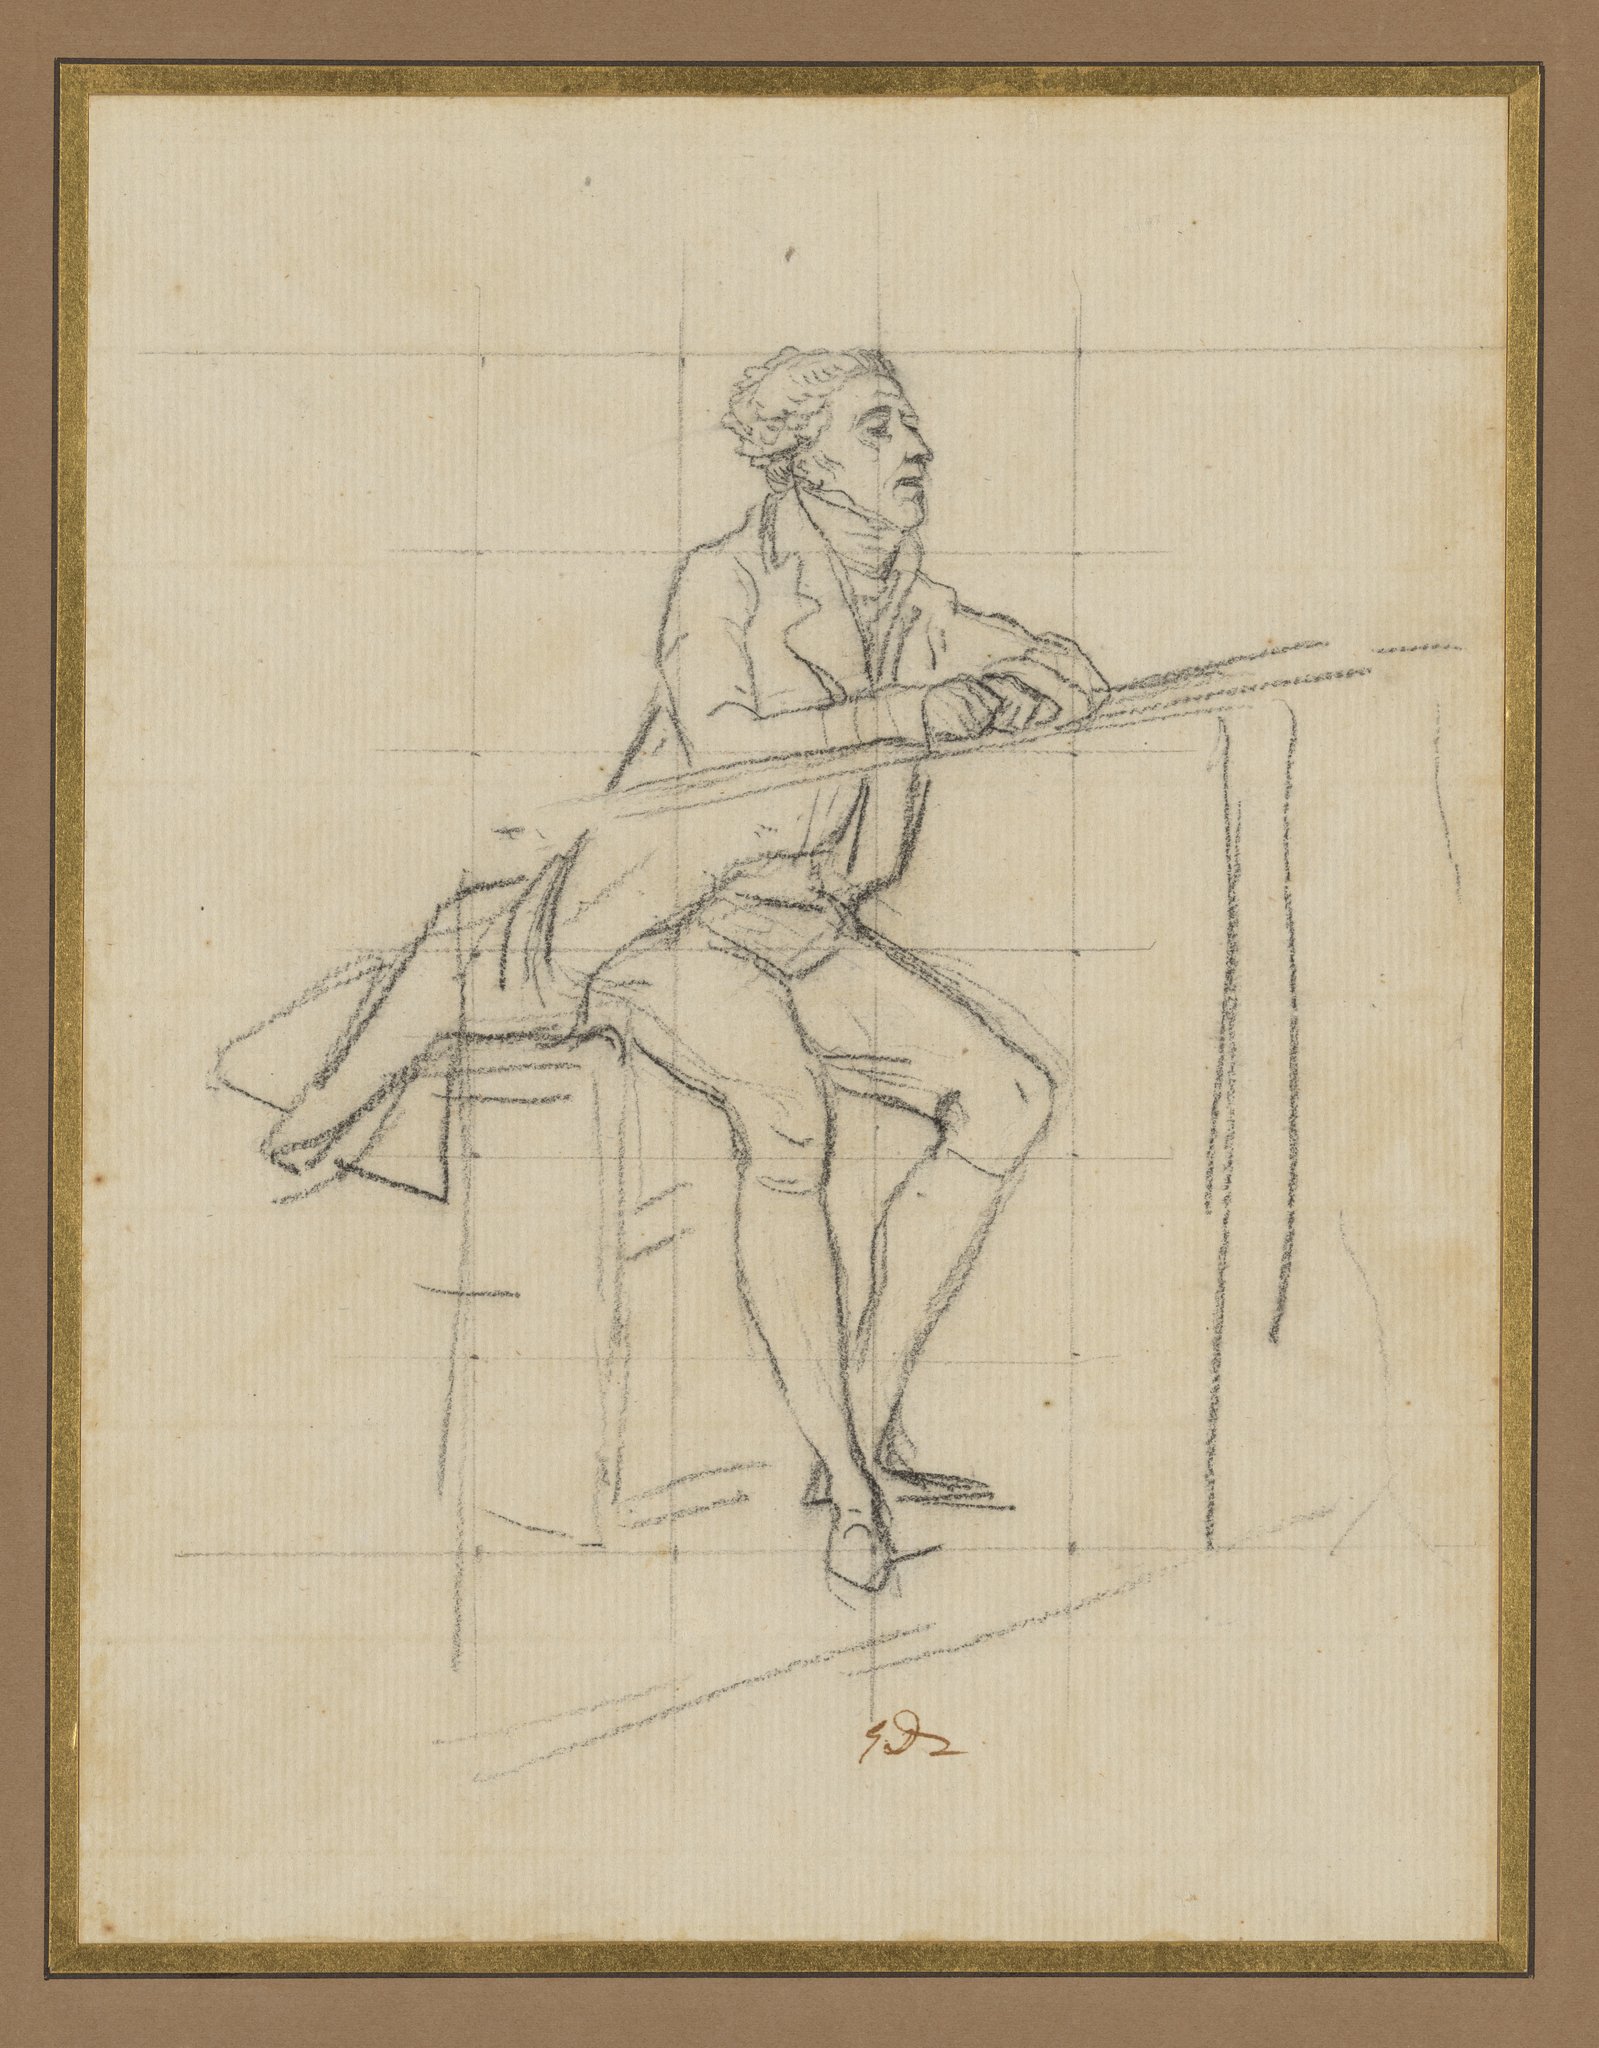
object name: drawing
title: Seated Gentleman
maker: jacques louis david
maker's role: artist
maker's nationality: french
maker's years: 1748-1825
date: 1810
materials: chalk, paper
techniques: drawing, transfer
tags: men